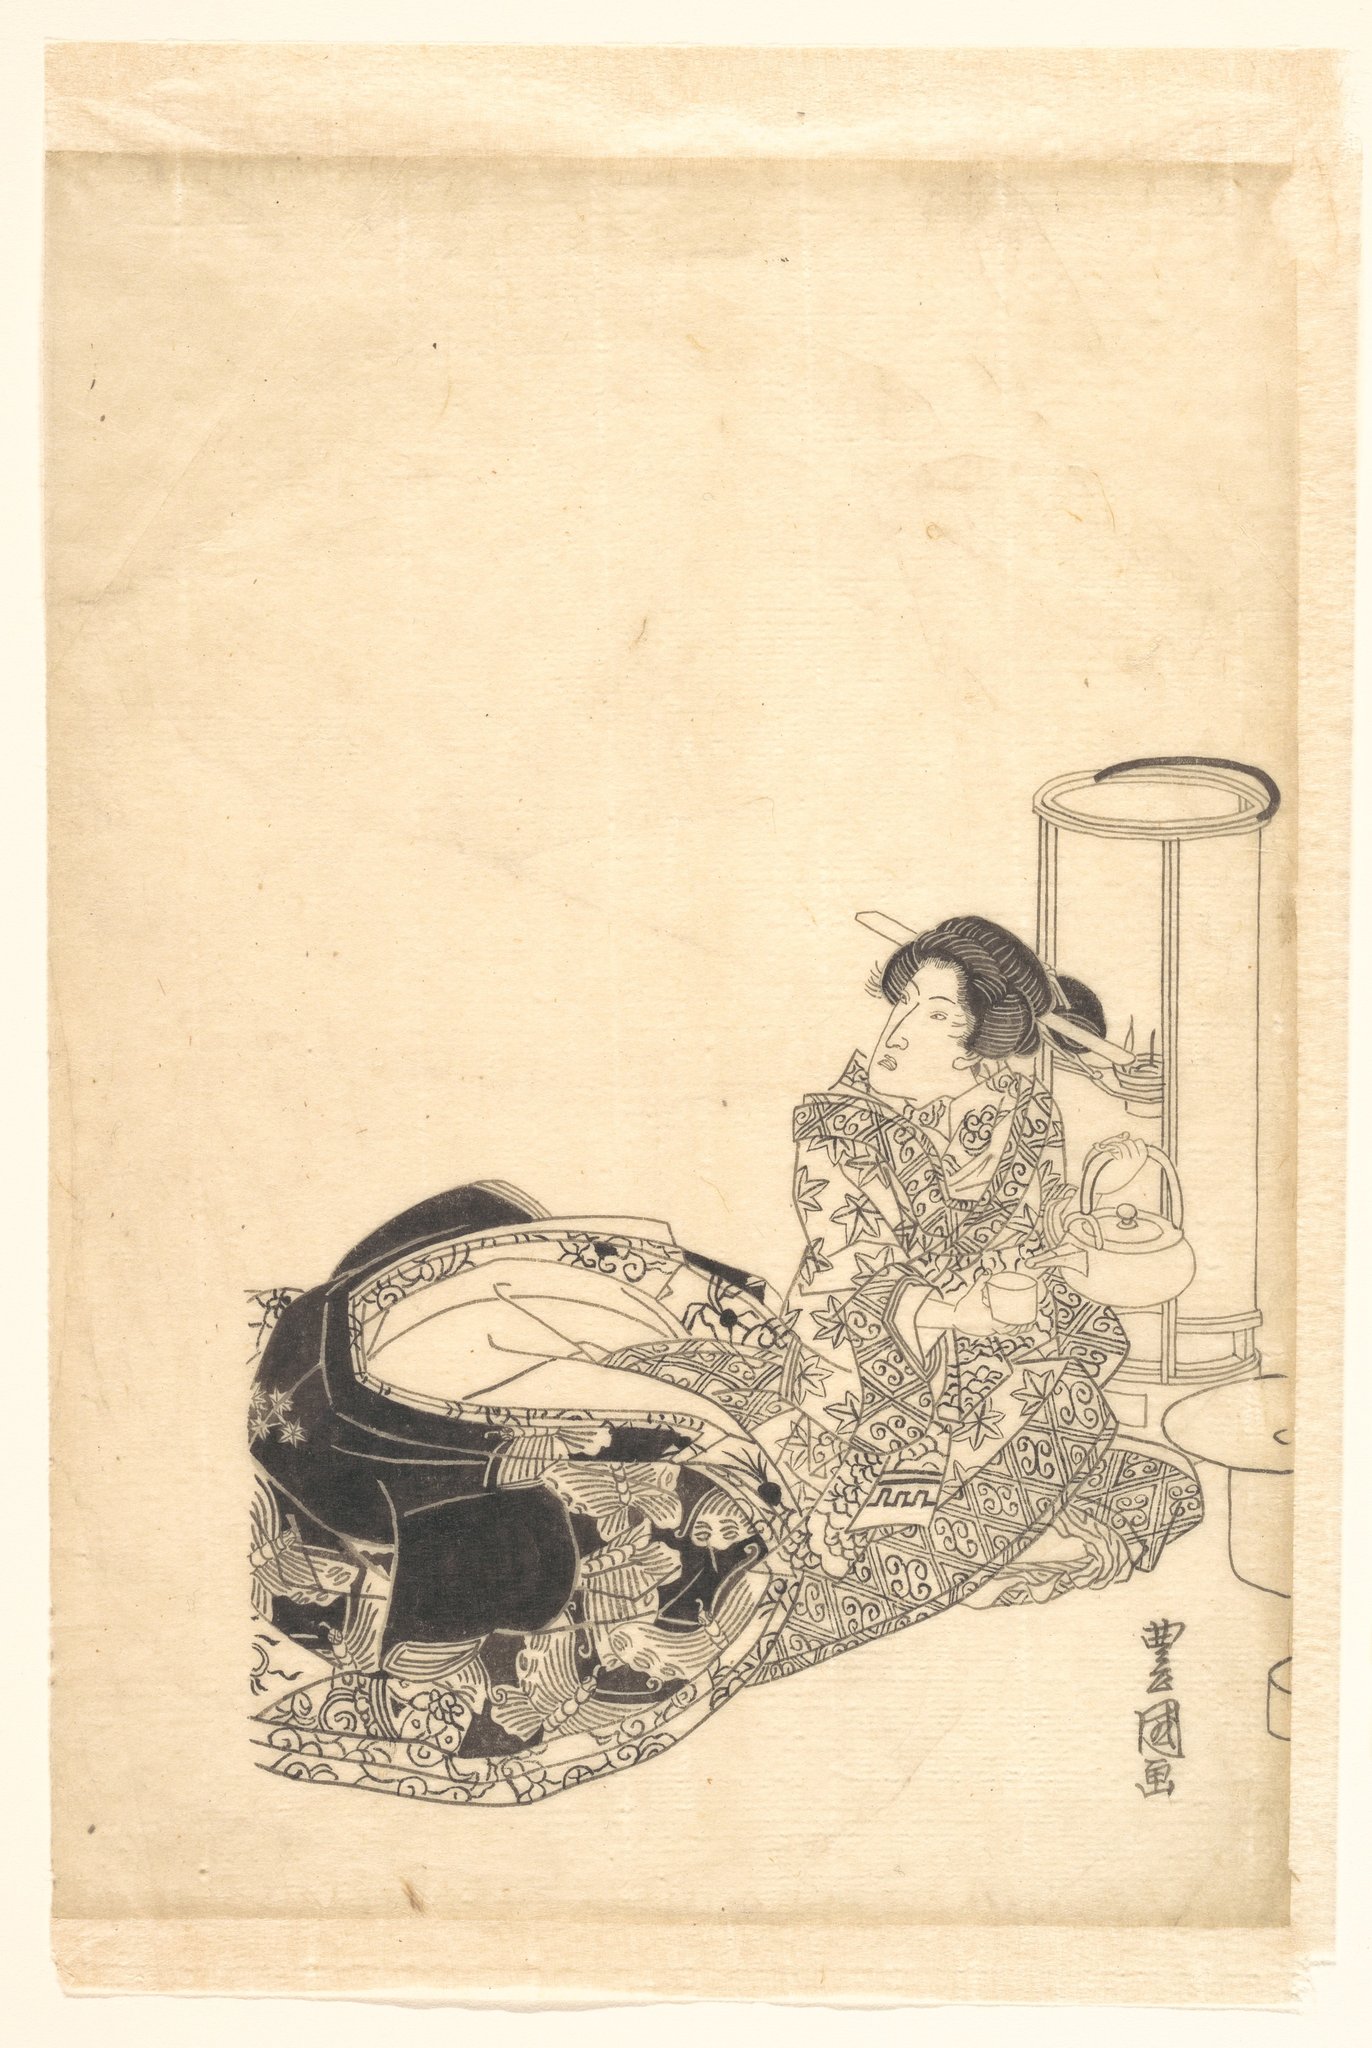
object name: print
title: Courtesan or Actor as Courtesan Pouring Tea by the Light of a Lantern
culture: japanese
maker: utagawa toyokuni i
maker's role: artist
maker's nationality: japanese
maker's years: 1769-1825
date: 1769-1825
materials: ink, paper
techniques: woodblock print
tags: women,actors,tea